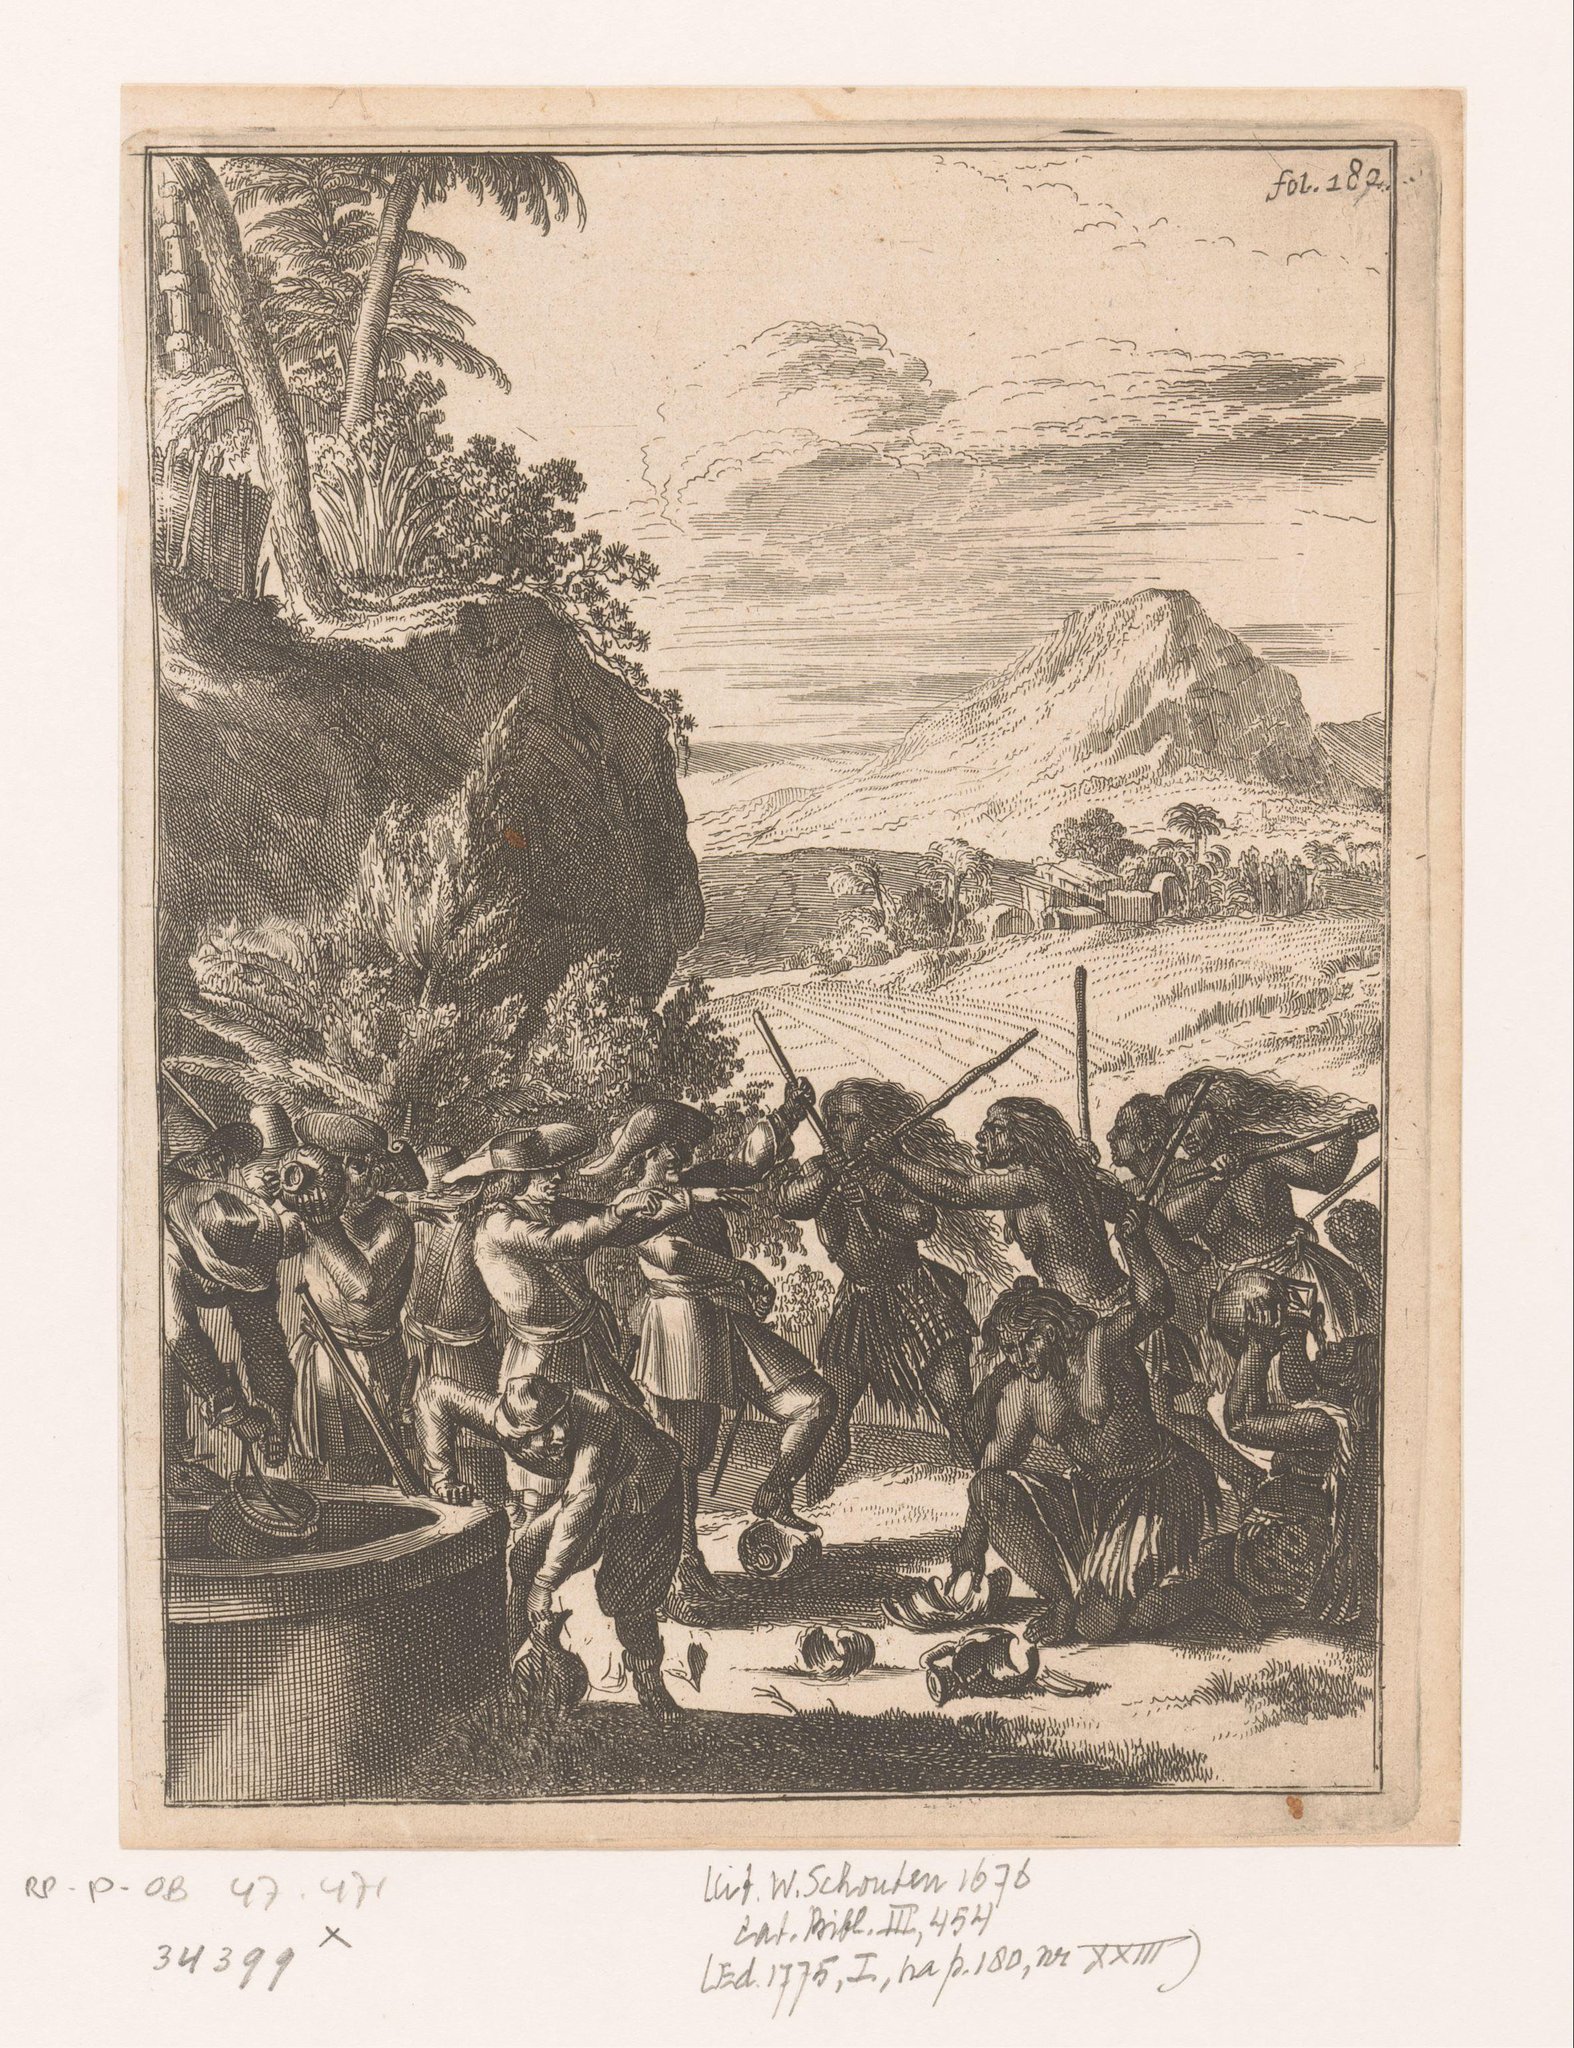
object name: print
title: Indiase vrouwen slaan de kruiken stuk waaruit de Nederlanders dronken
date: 1676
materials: paper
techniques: engraving, etching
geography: amsterdam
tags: fighting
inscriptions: collector's mark: Lugt 2228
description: Met stokken gewapende halfnaakte Indiase vrouwen (in de tekst aangeduid als Jentyven uit Satrispatnam) slaan de kruiken stuk waaruit de Nederlanders op een warme dag water dronken uit een put.